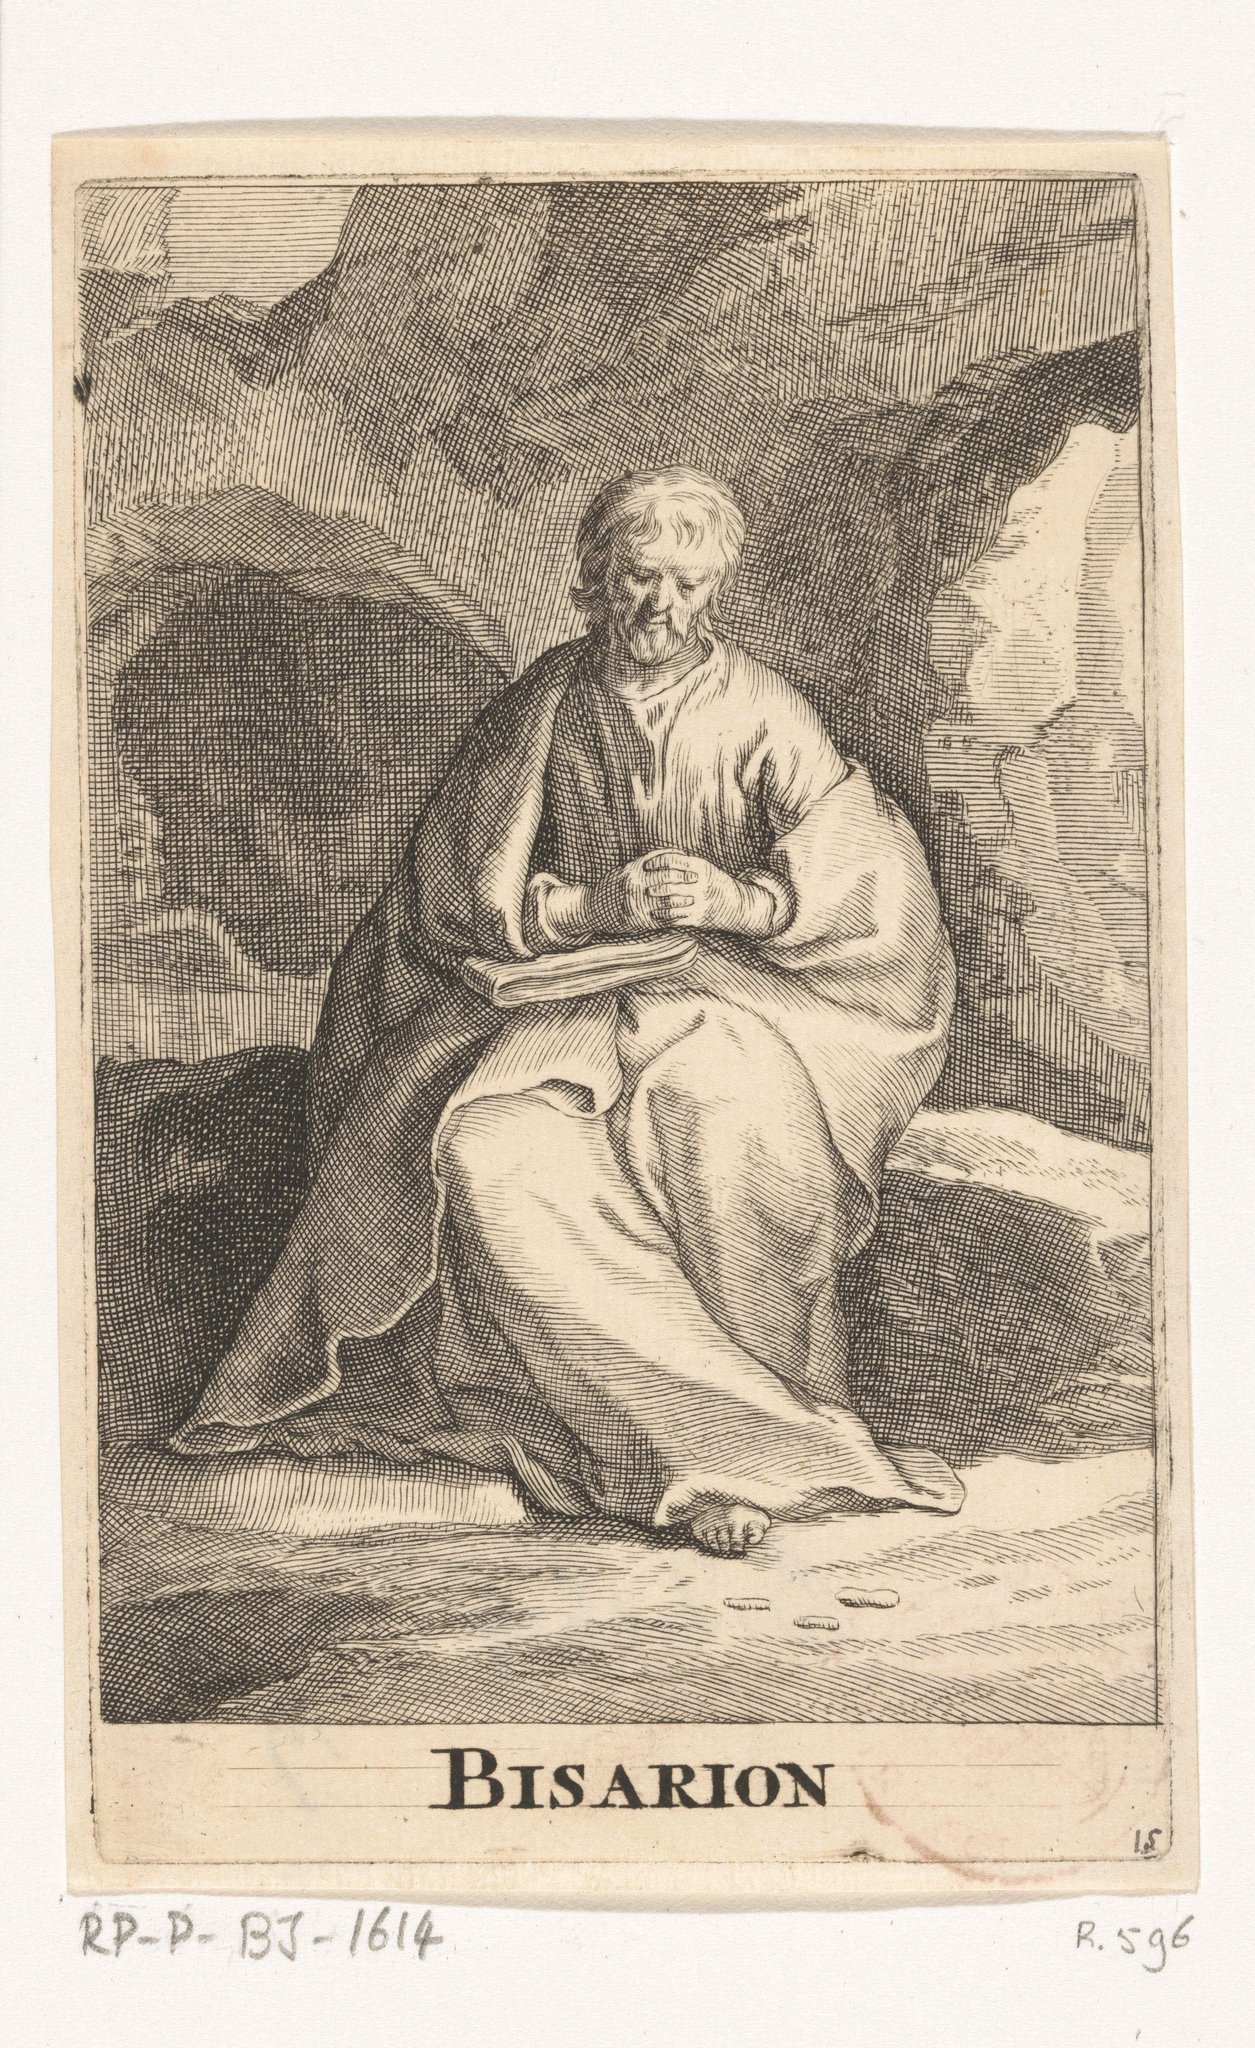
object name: print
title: Kluizenaars: Thebaanse heiligen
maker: frederick bloemaert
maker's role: print maker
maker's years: 1614-1669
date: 1636-1670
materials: paper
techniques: engraving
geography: utrecht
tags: male saints (bisarion)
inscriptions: collector's mark: Lugt 240, number: ‘15’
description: De heilige Bessarion van Egypte zittend in een grot met een boek op schoot en de handen gevouwen. Prent uit een serie van 80 prenten en een titelprent met kluizenaars uit de 2e tot de 6e eeuw.